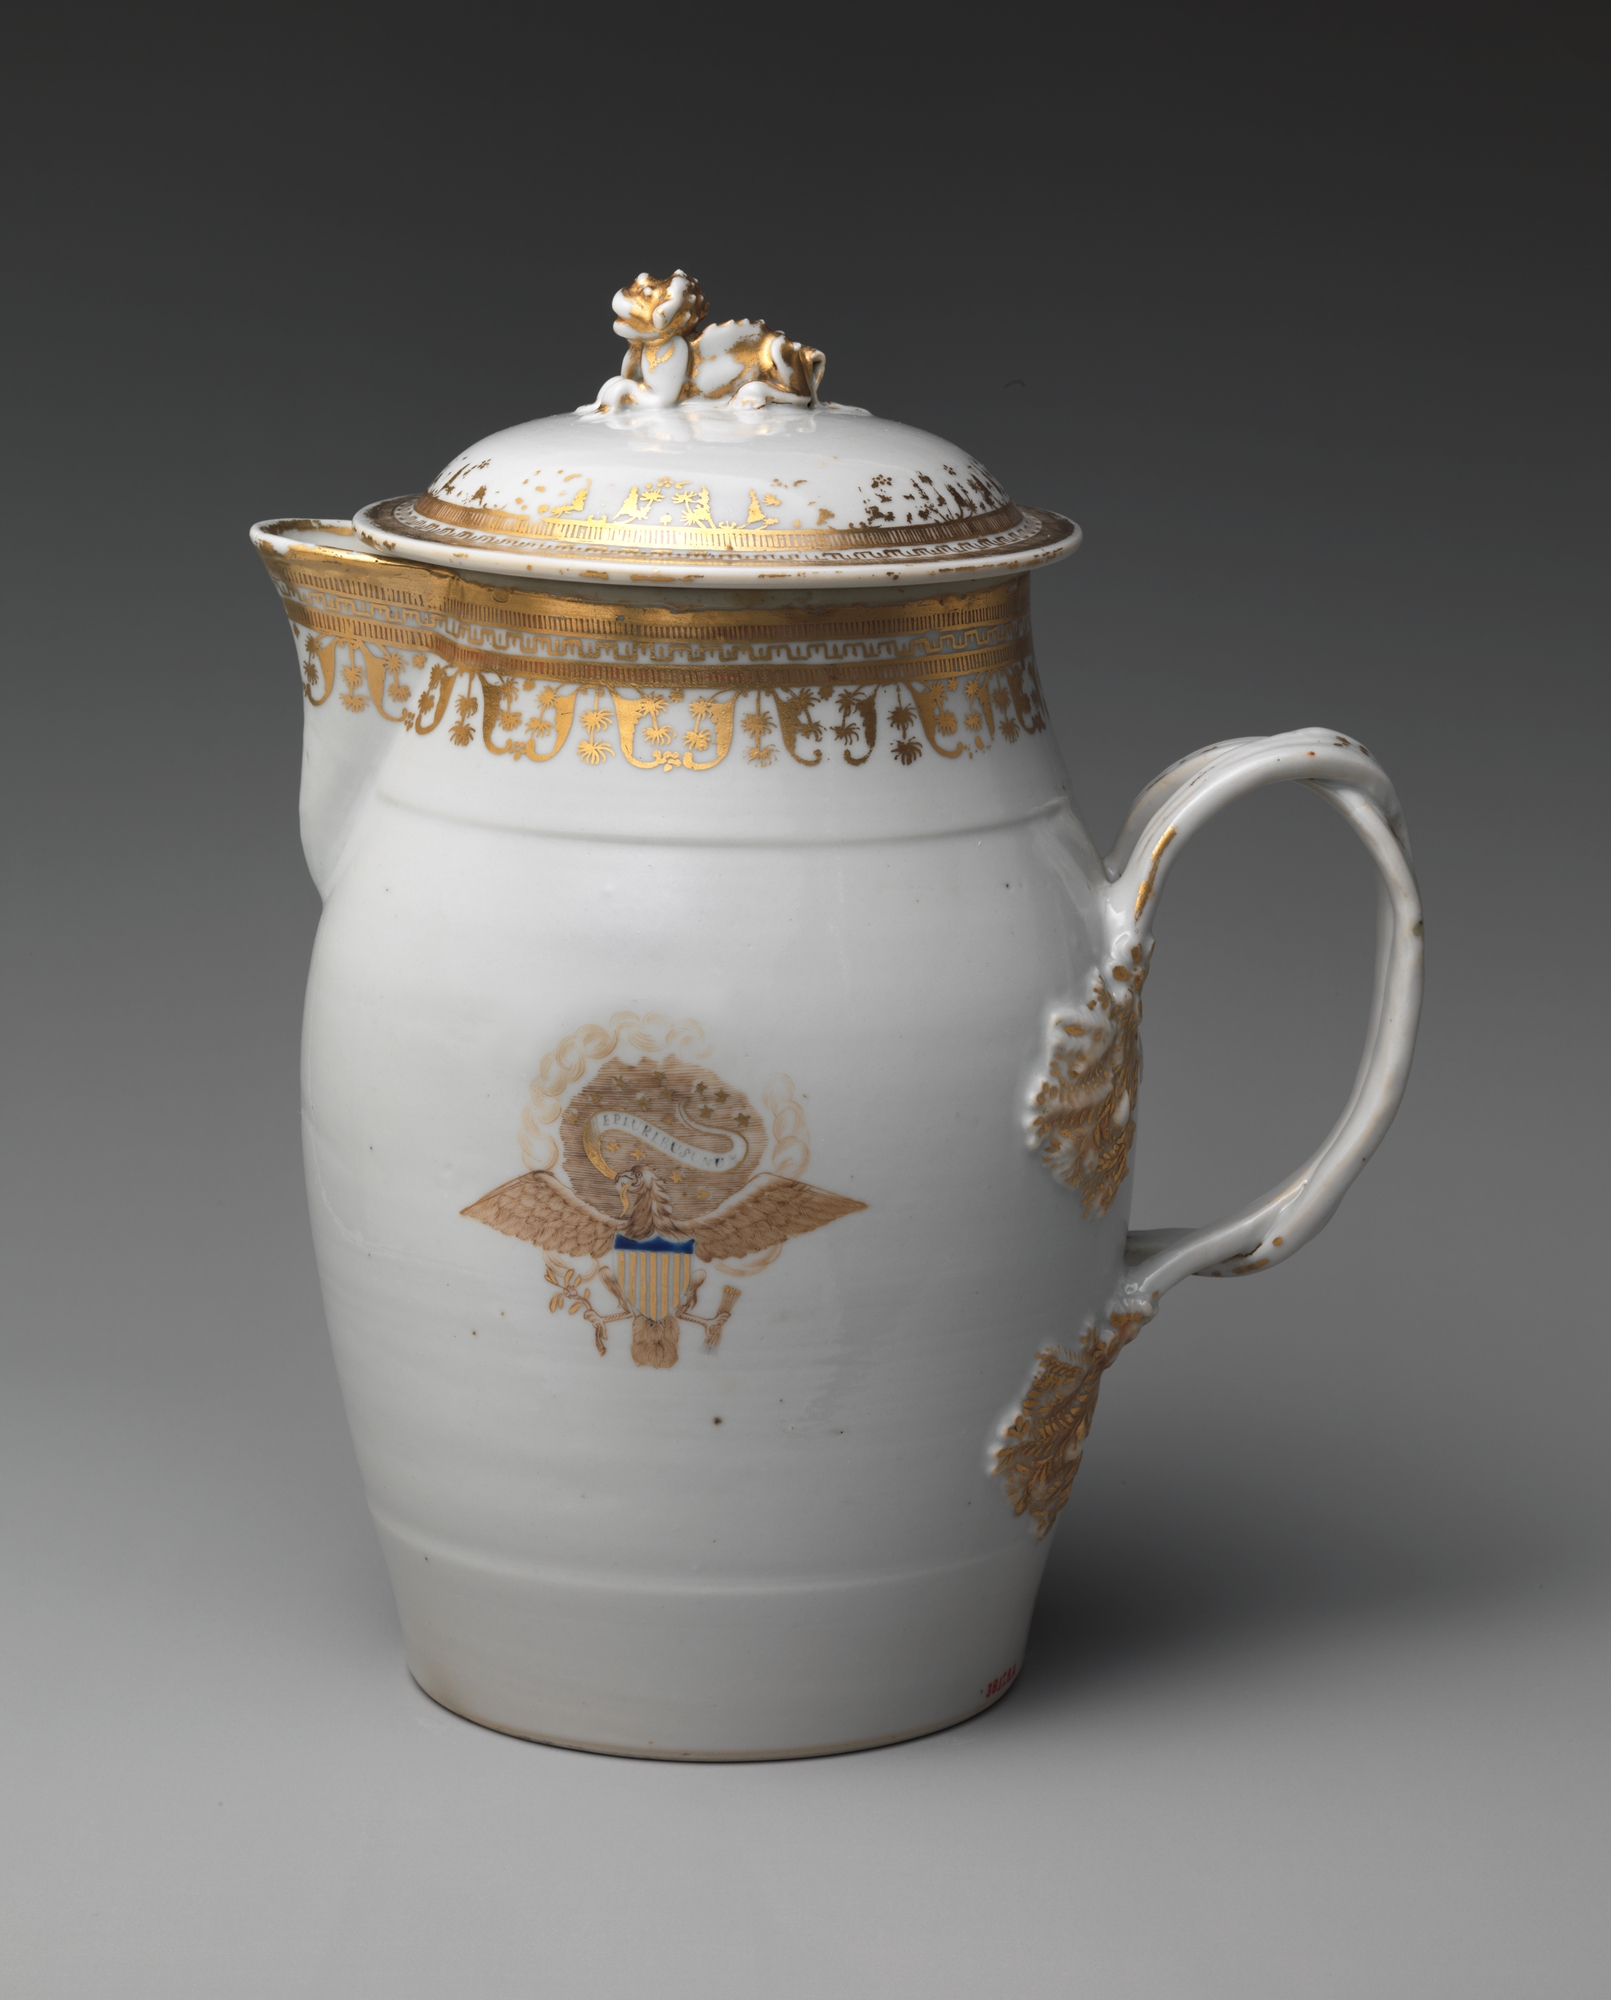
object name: toddy jug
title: Covered Toddy Jug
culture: chinese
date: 1792-1796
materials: porcelain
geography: china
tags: eagles